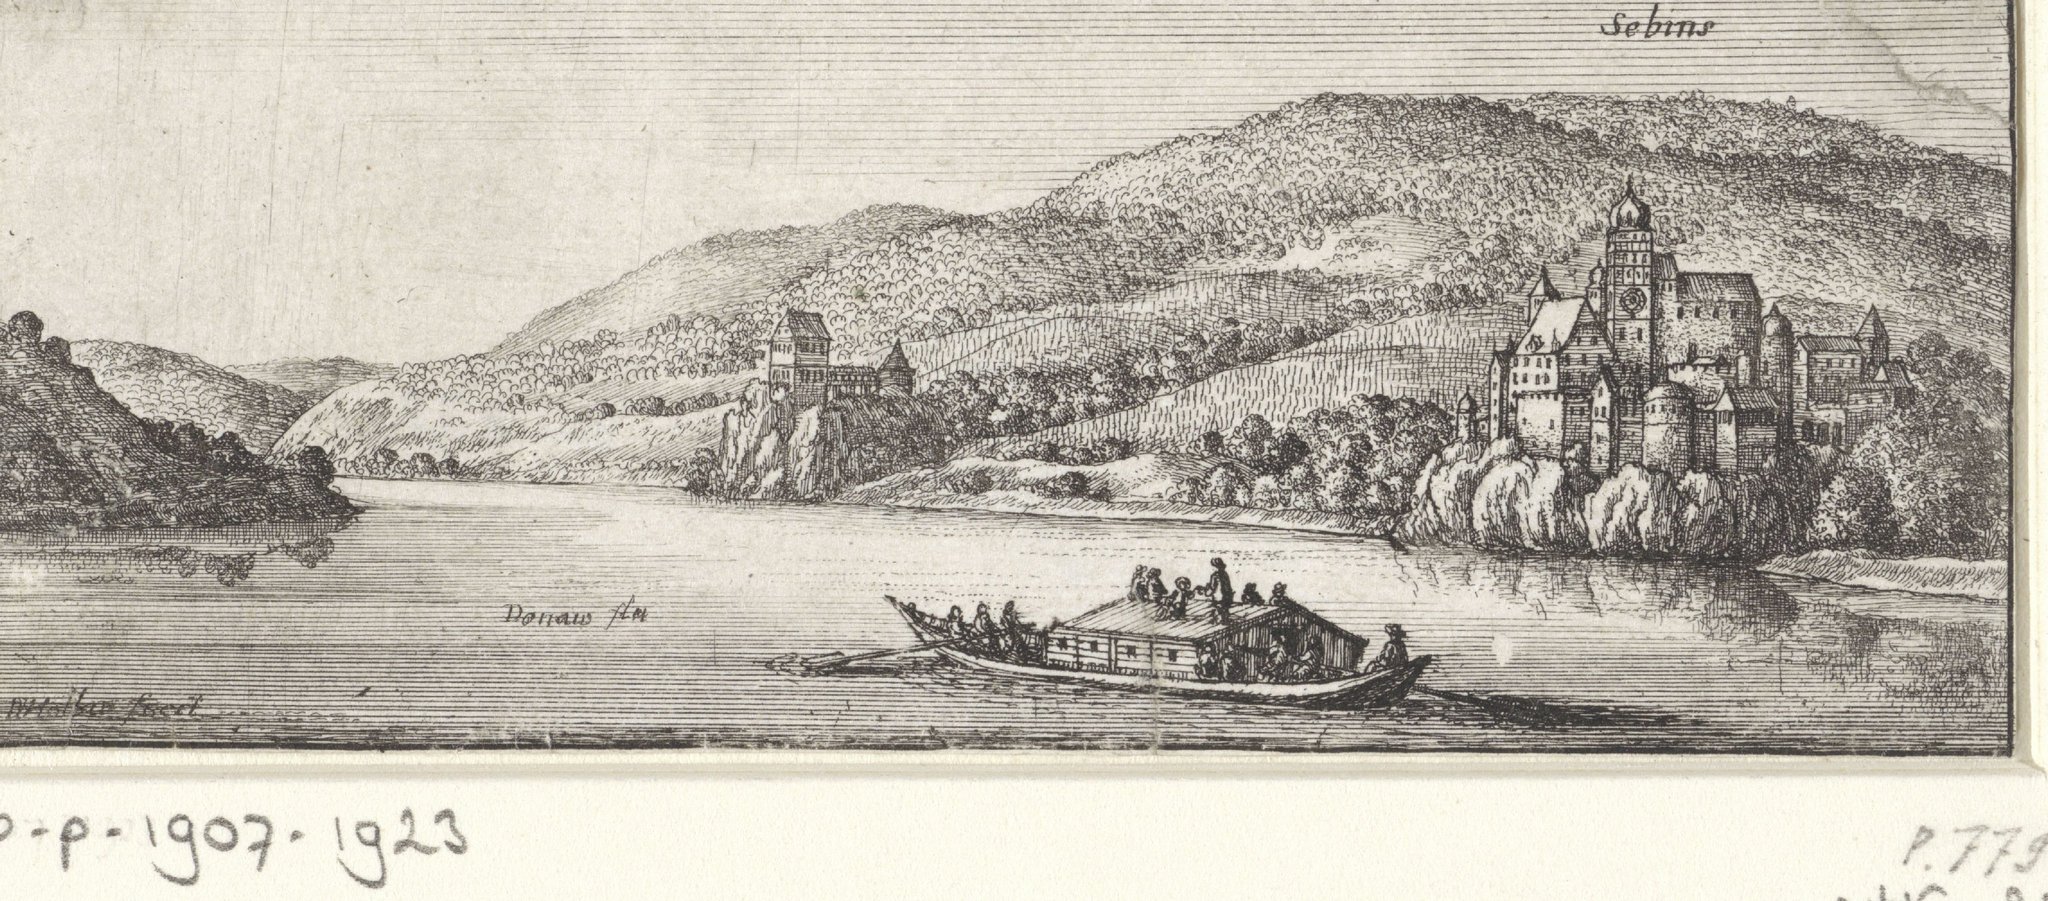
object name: print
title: Landschap met gezicht op Sebins aan de Donau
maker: wenceslaus hollar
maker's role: draughtsman, print maker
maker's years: 1607-1677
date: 1625-1677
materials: paper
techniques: etching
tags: city-view, and landscape with man-made constructions, river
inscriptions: collector's mark: Lugt 2228